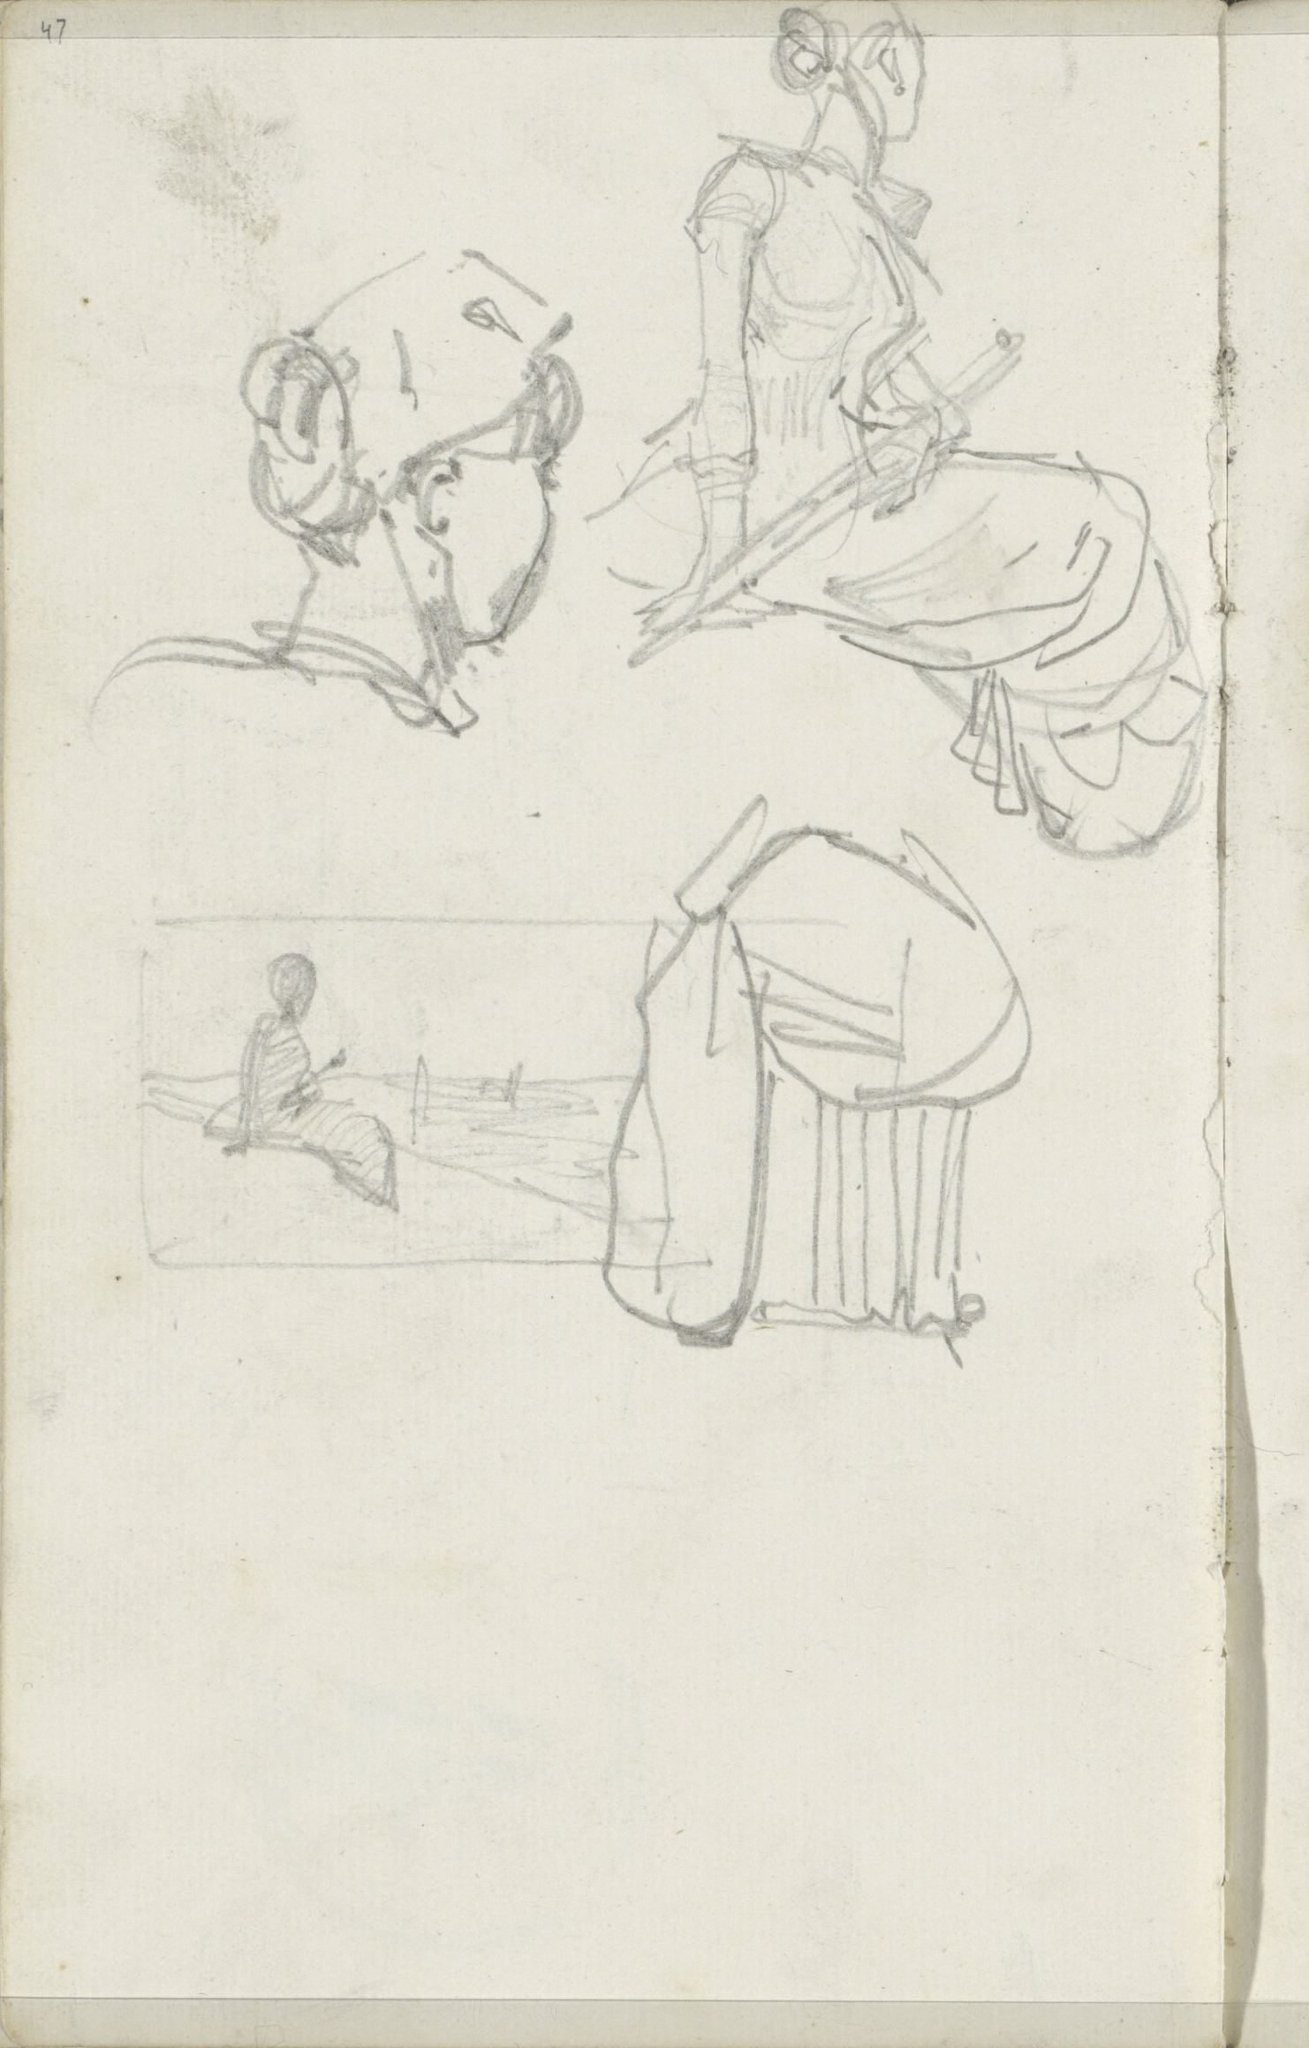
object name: sketchbook leaf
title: Studies van een zittende vrouw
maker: george hendrik breitner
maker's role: draughtsman, painter, print maker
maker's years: 1857-1923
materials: paper, pencil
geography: the hague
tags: adult woman, landscapes, sitting figure - aa - female human figure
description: Pagina 47 uit een schetsboek met 28 bladen.